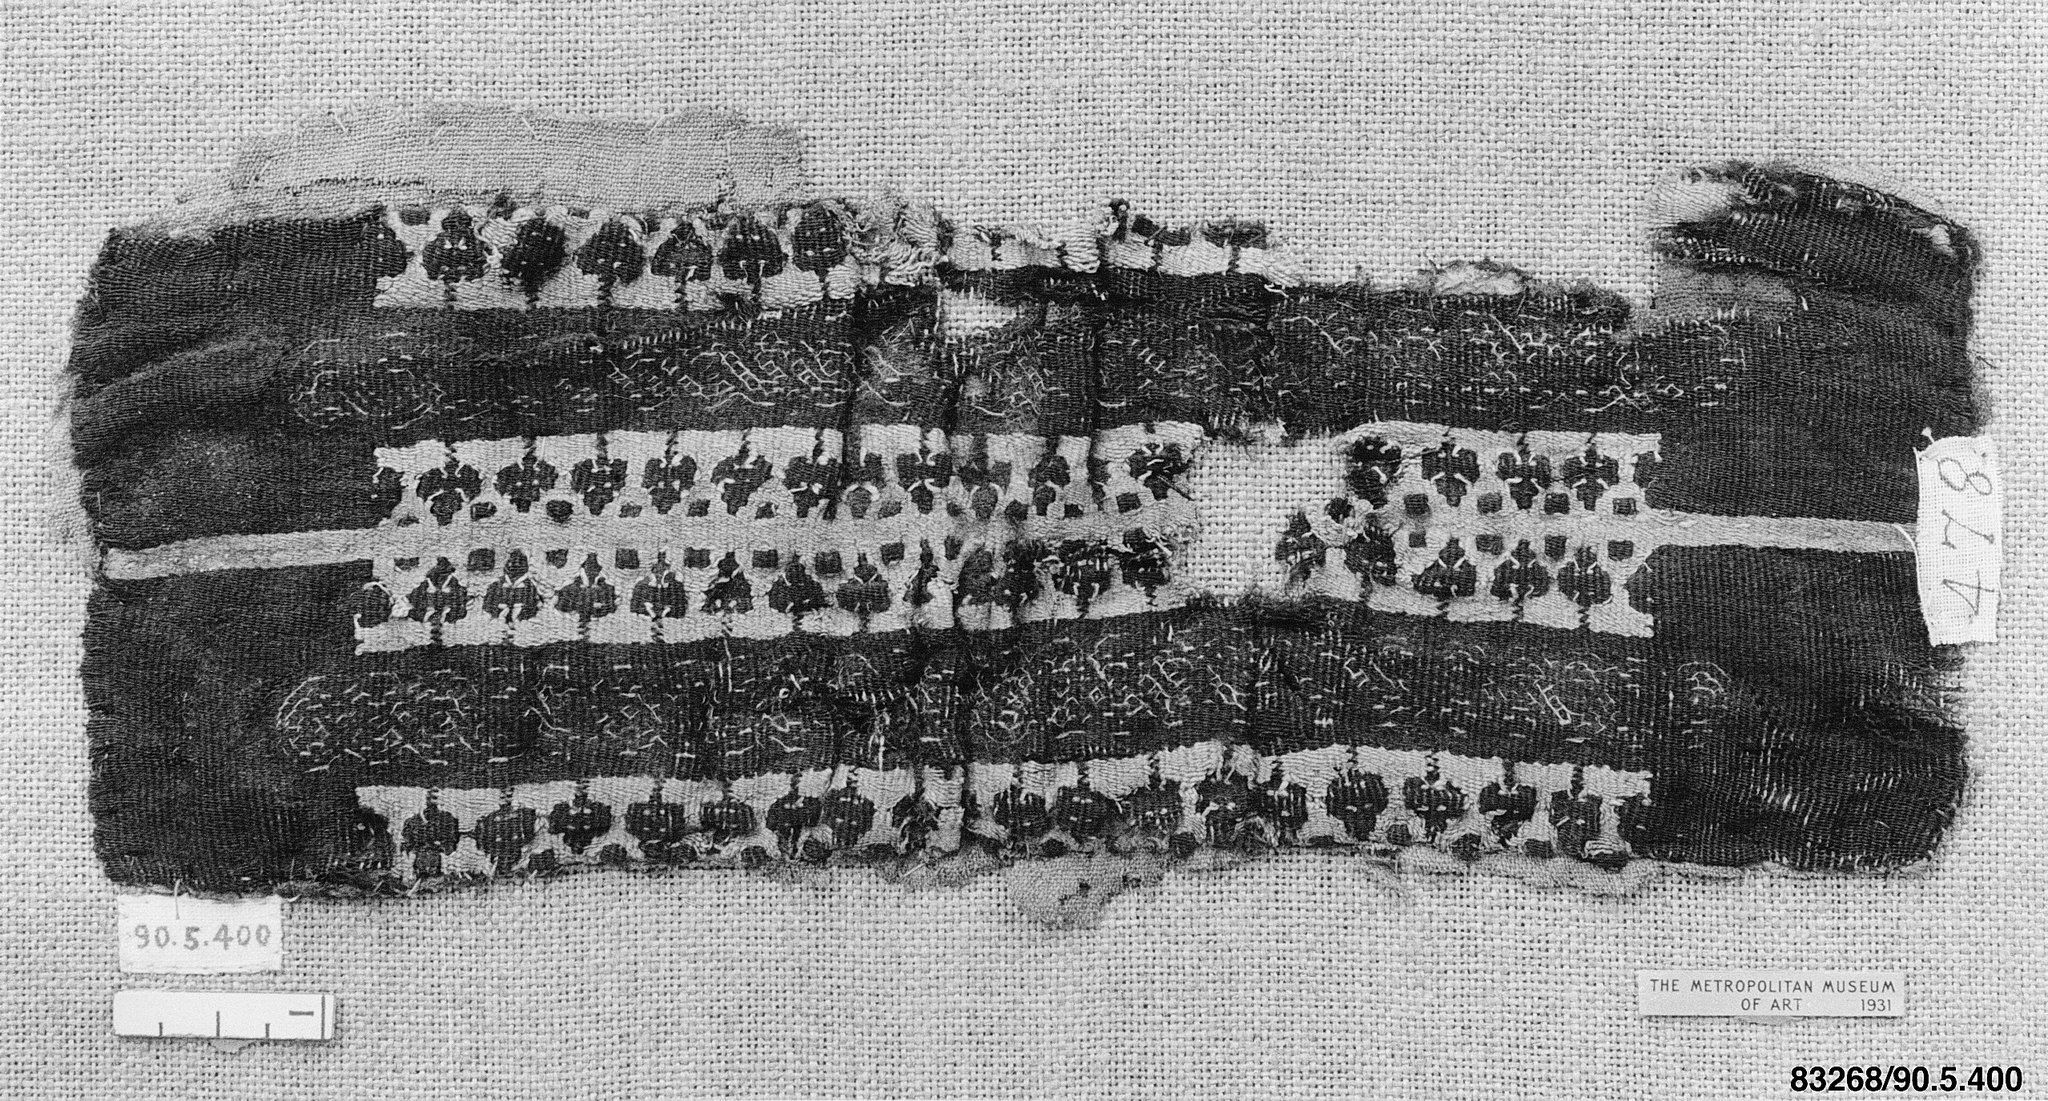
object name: textile fragment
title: Fragment of a Sleeve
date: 201-400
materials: linen, wool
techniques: weave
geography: egypt